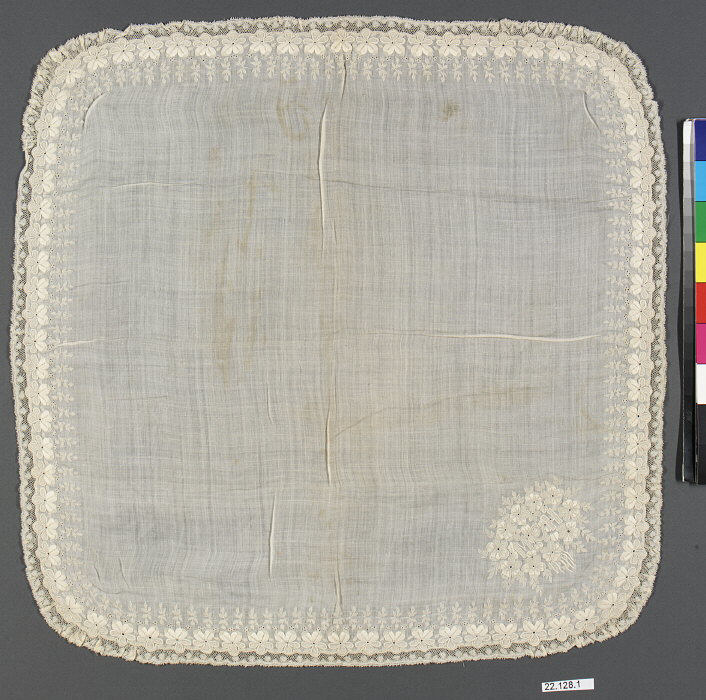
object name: handkerchief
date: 1863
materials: linen